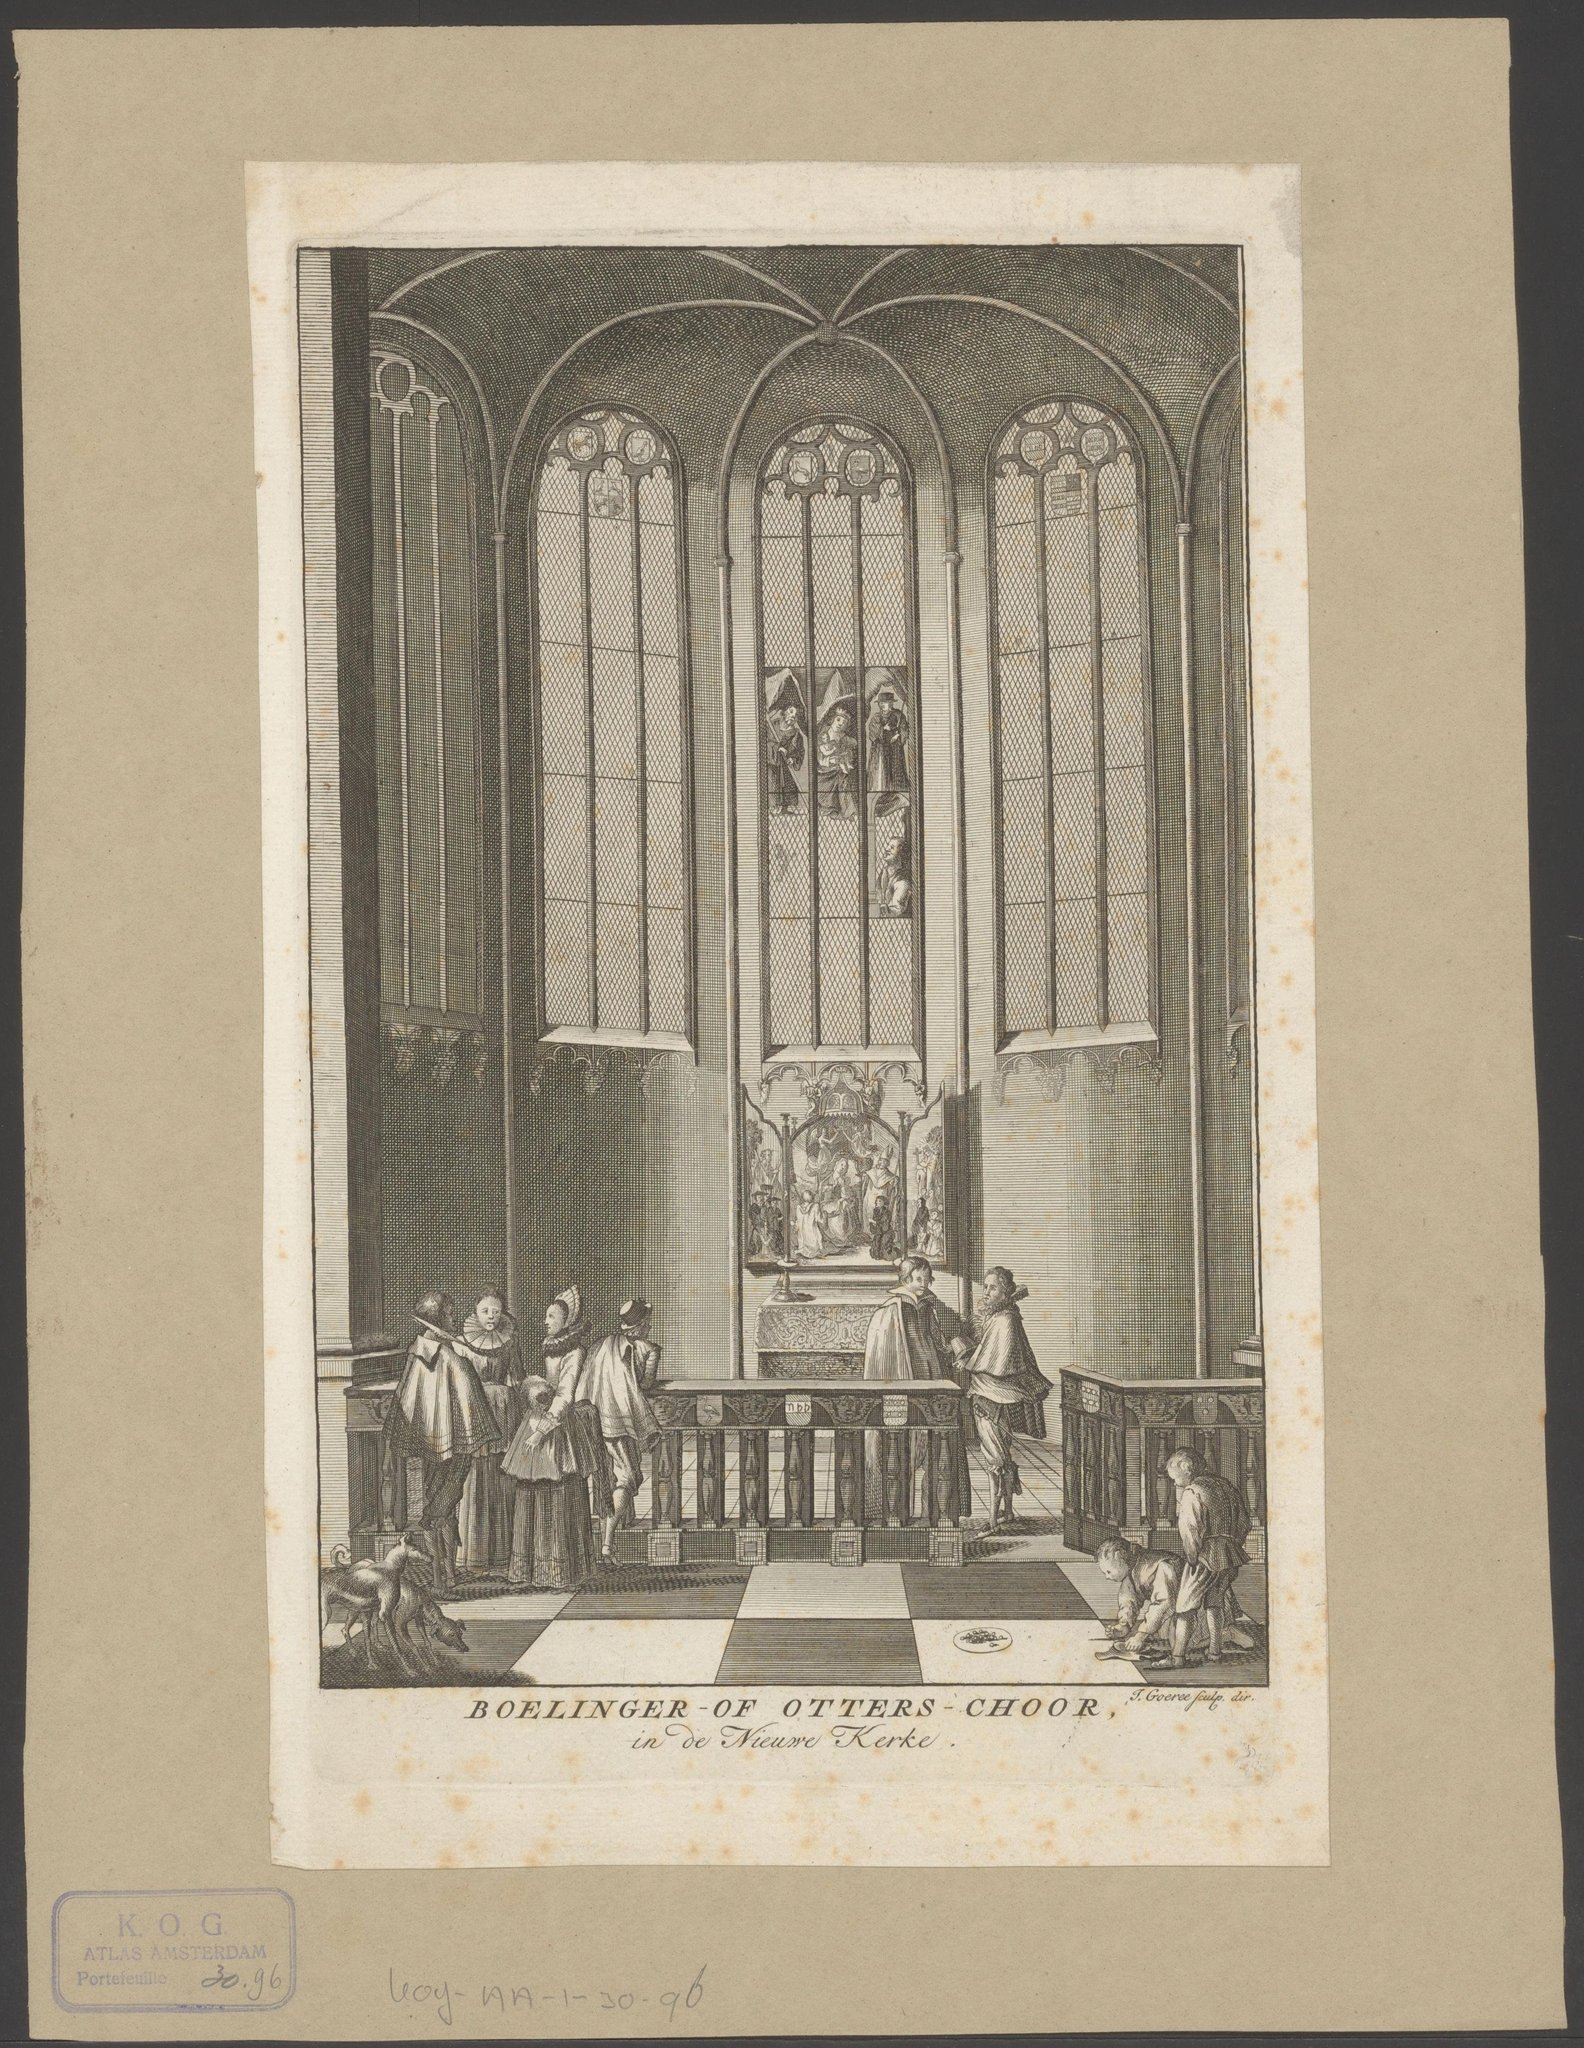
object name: print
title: Boelinger- of Otters-choor, in de Nieuwe Kerk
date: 1765-1782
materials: paper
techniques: engraving, etching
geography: amsterdam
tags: parts of church interior: chapel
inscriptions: collector's mark: Lugt 1641b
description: Prent mogelijk uit: Wagenaar, Jan. Amsterdam, in zyne opkomst, aanwas, geschiedenissen (…). Amsterdam: Isaak Tirion, 1765, dl. 2. Of uit: Verzameling der fraaiste gezigten van Amsterdam in negen en zeventig afbeeldingen. Amsterdam en Harlingen: Petrus Conradi en Volkert van der Plaats, 1782.